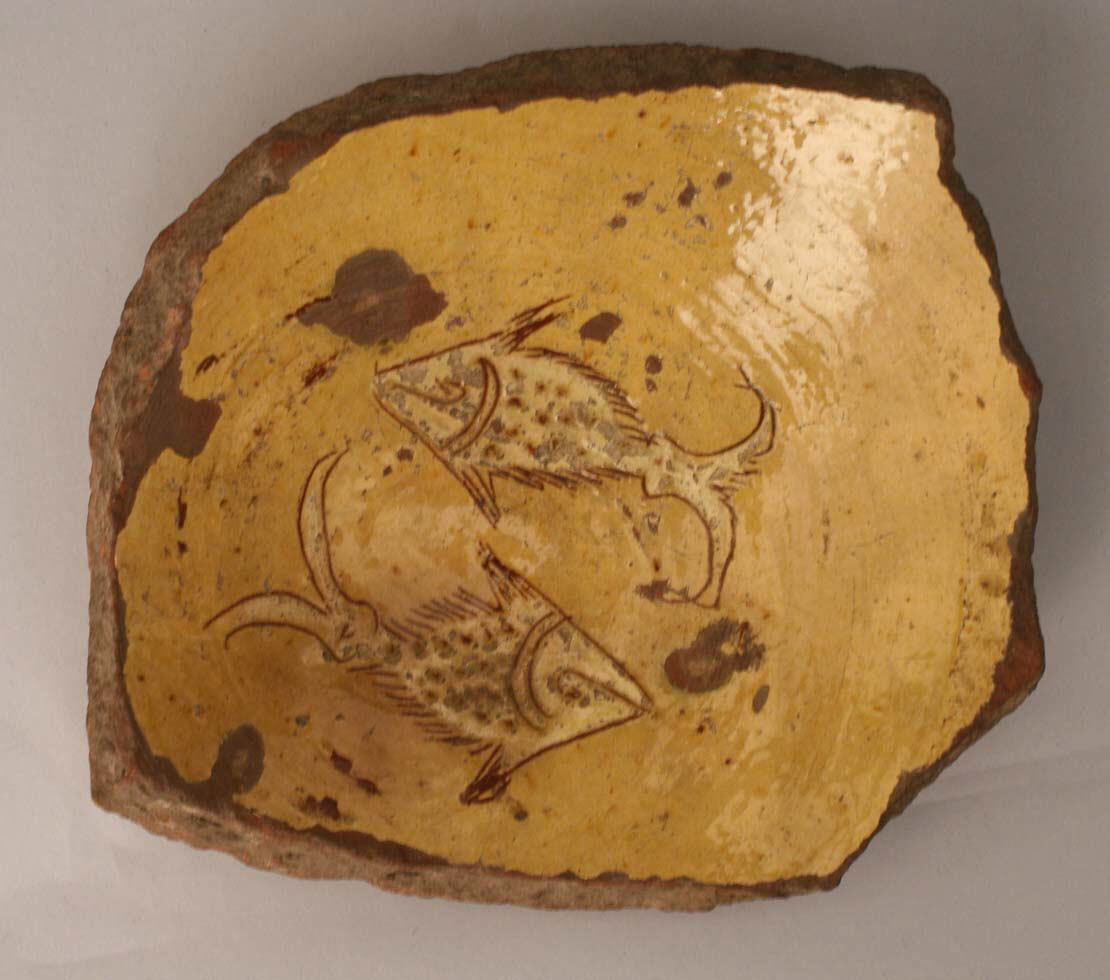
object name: fragment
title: Ceramic Fragment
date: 1301-1500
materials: earthenware, glaze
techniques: coloring, incising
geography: egypt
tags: fish